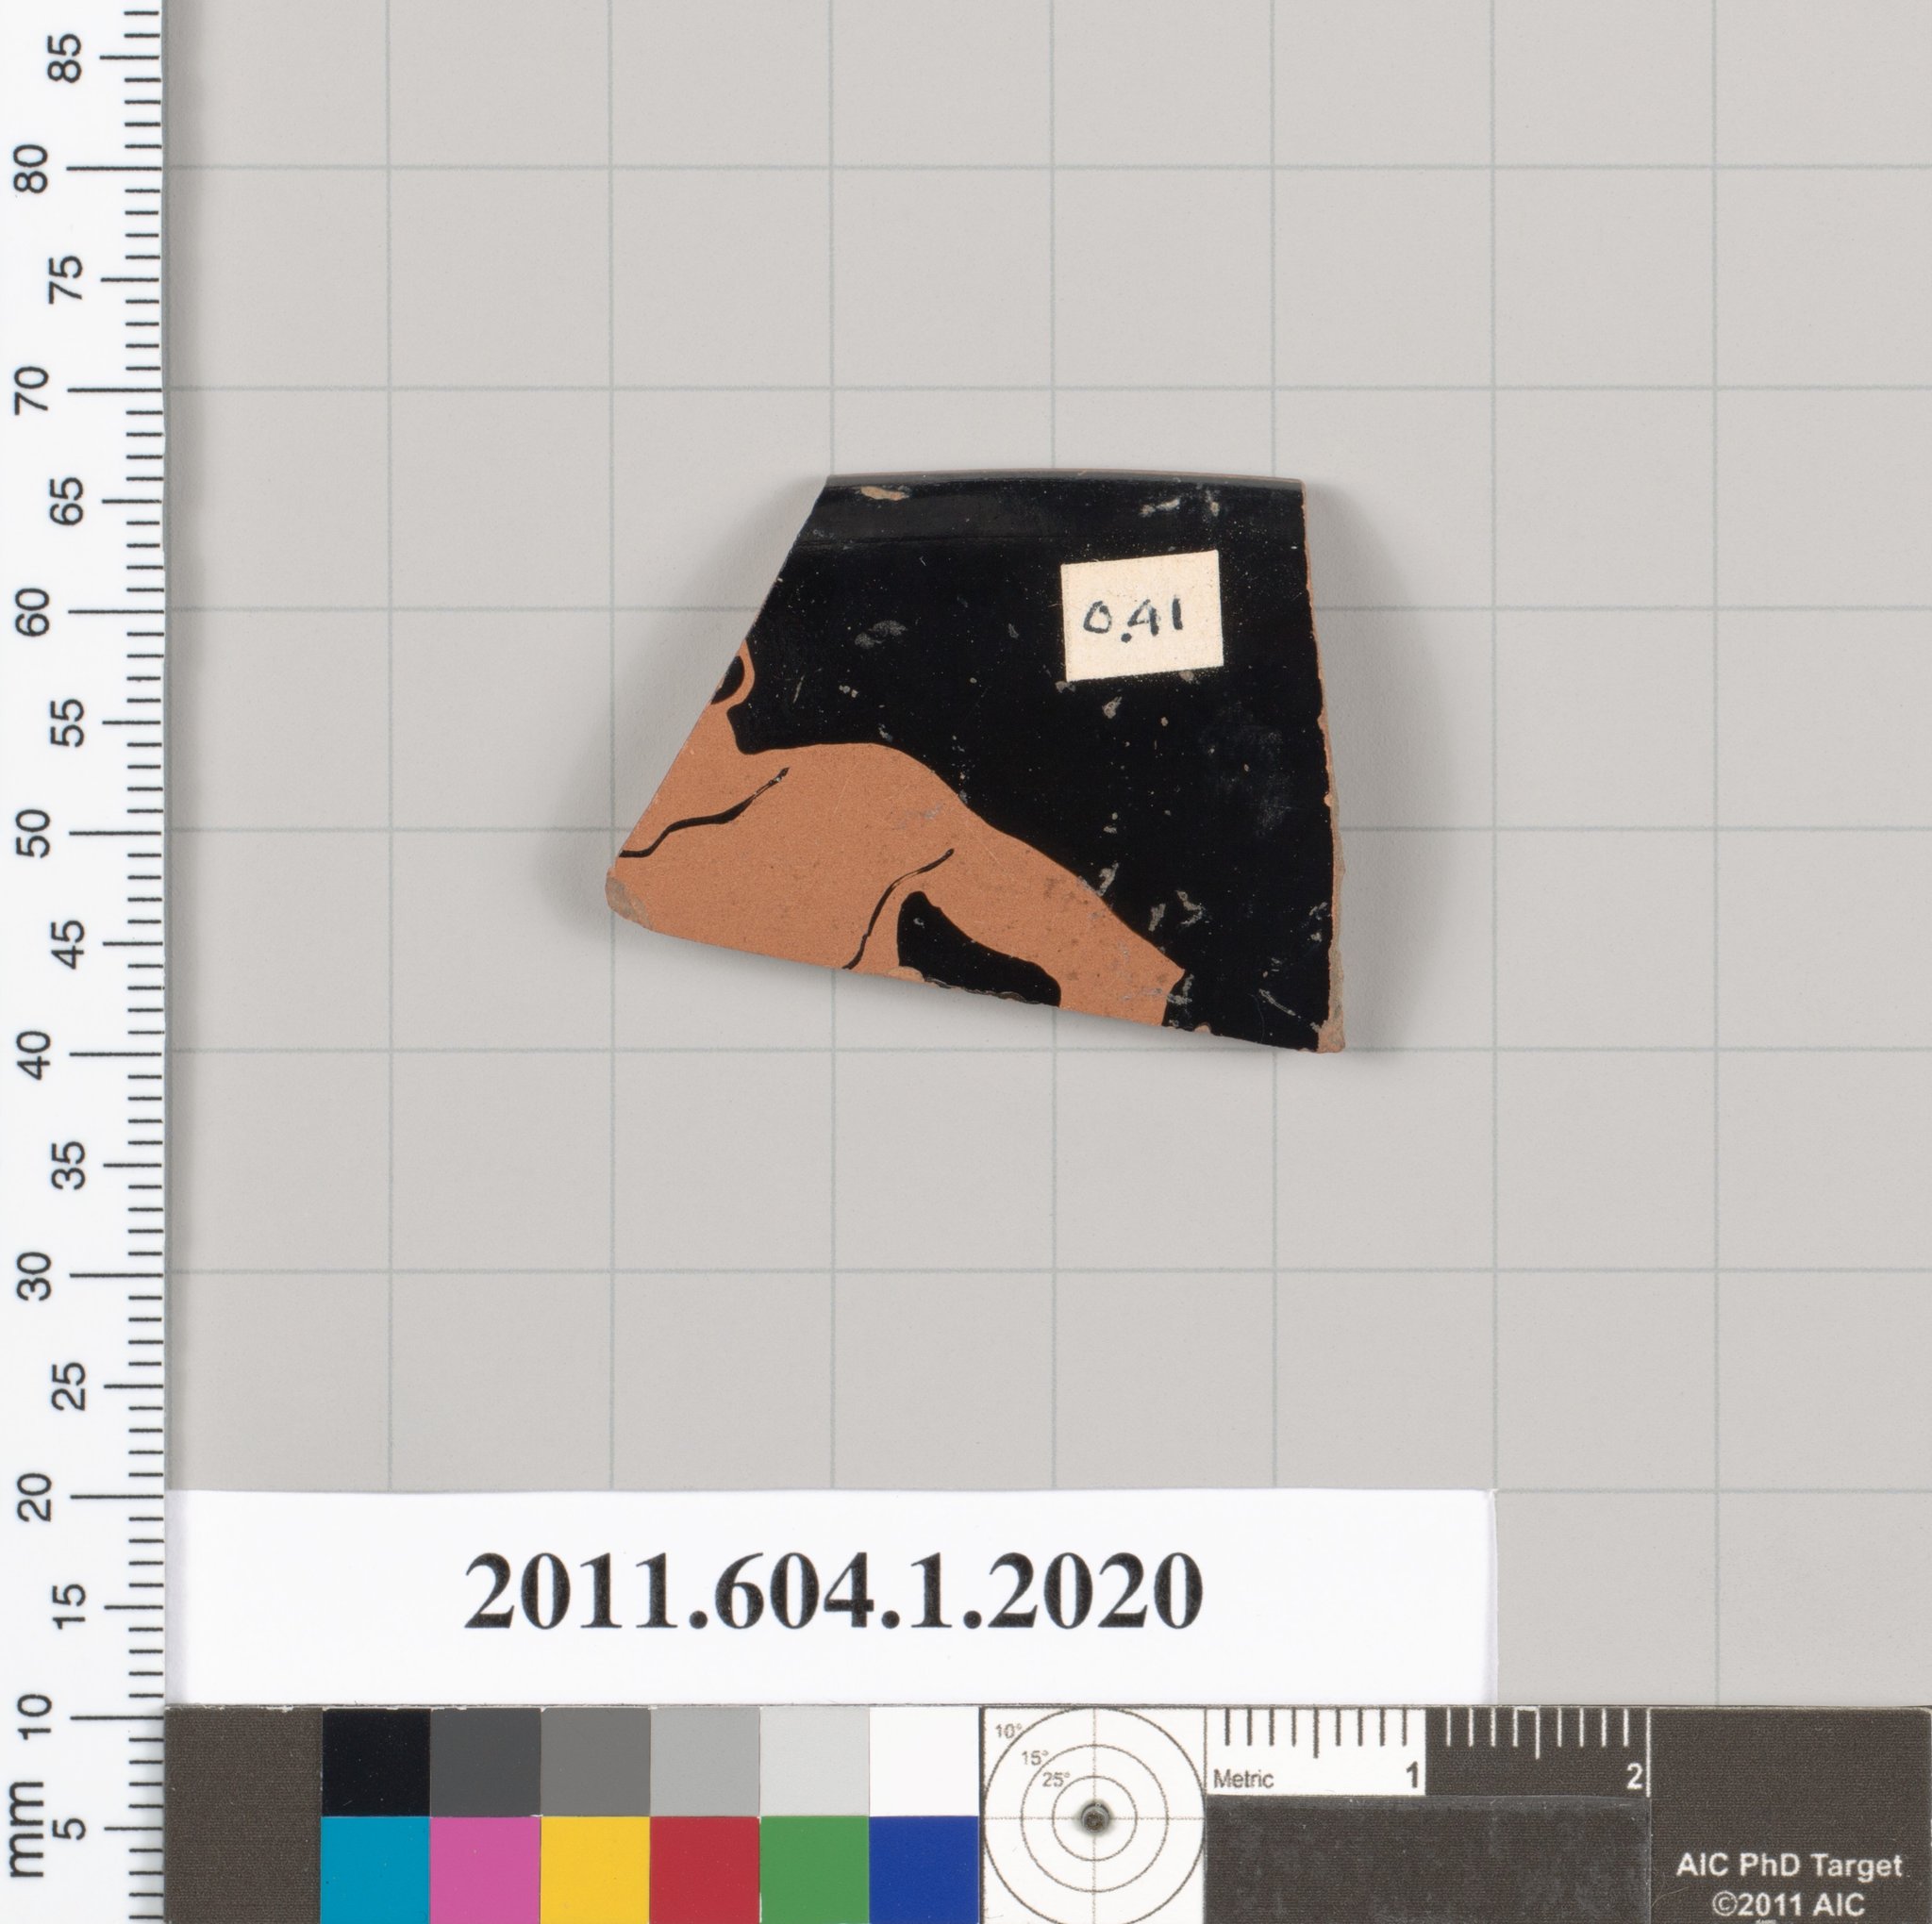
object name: kylix fragment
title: Terracotta rim fragment of a kylix (drinking cup)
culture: greek, attic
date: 475-451 BCE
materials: terracotta